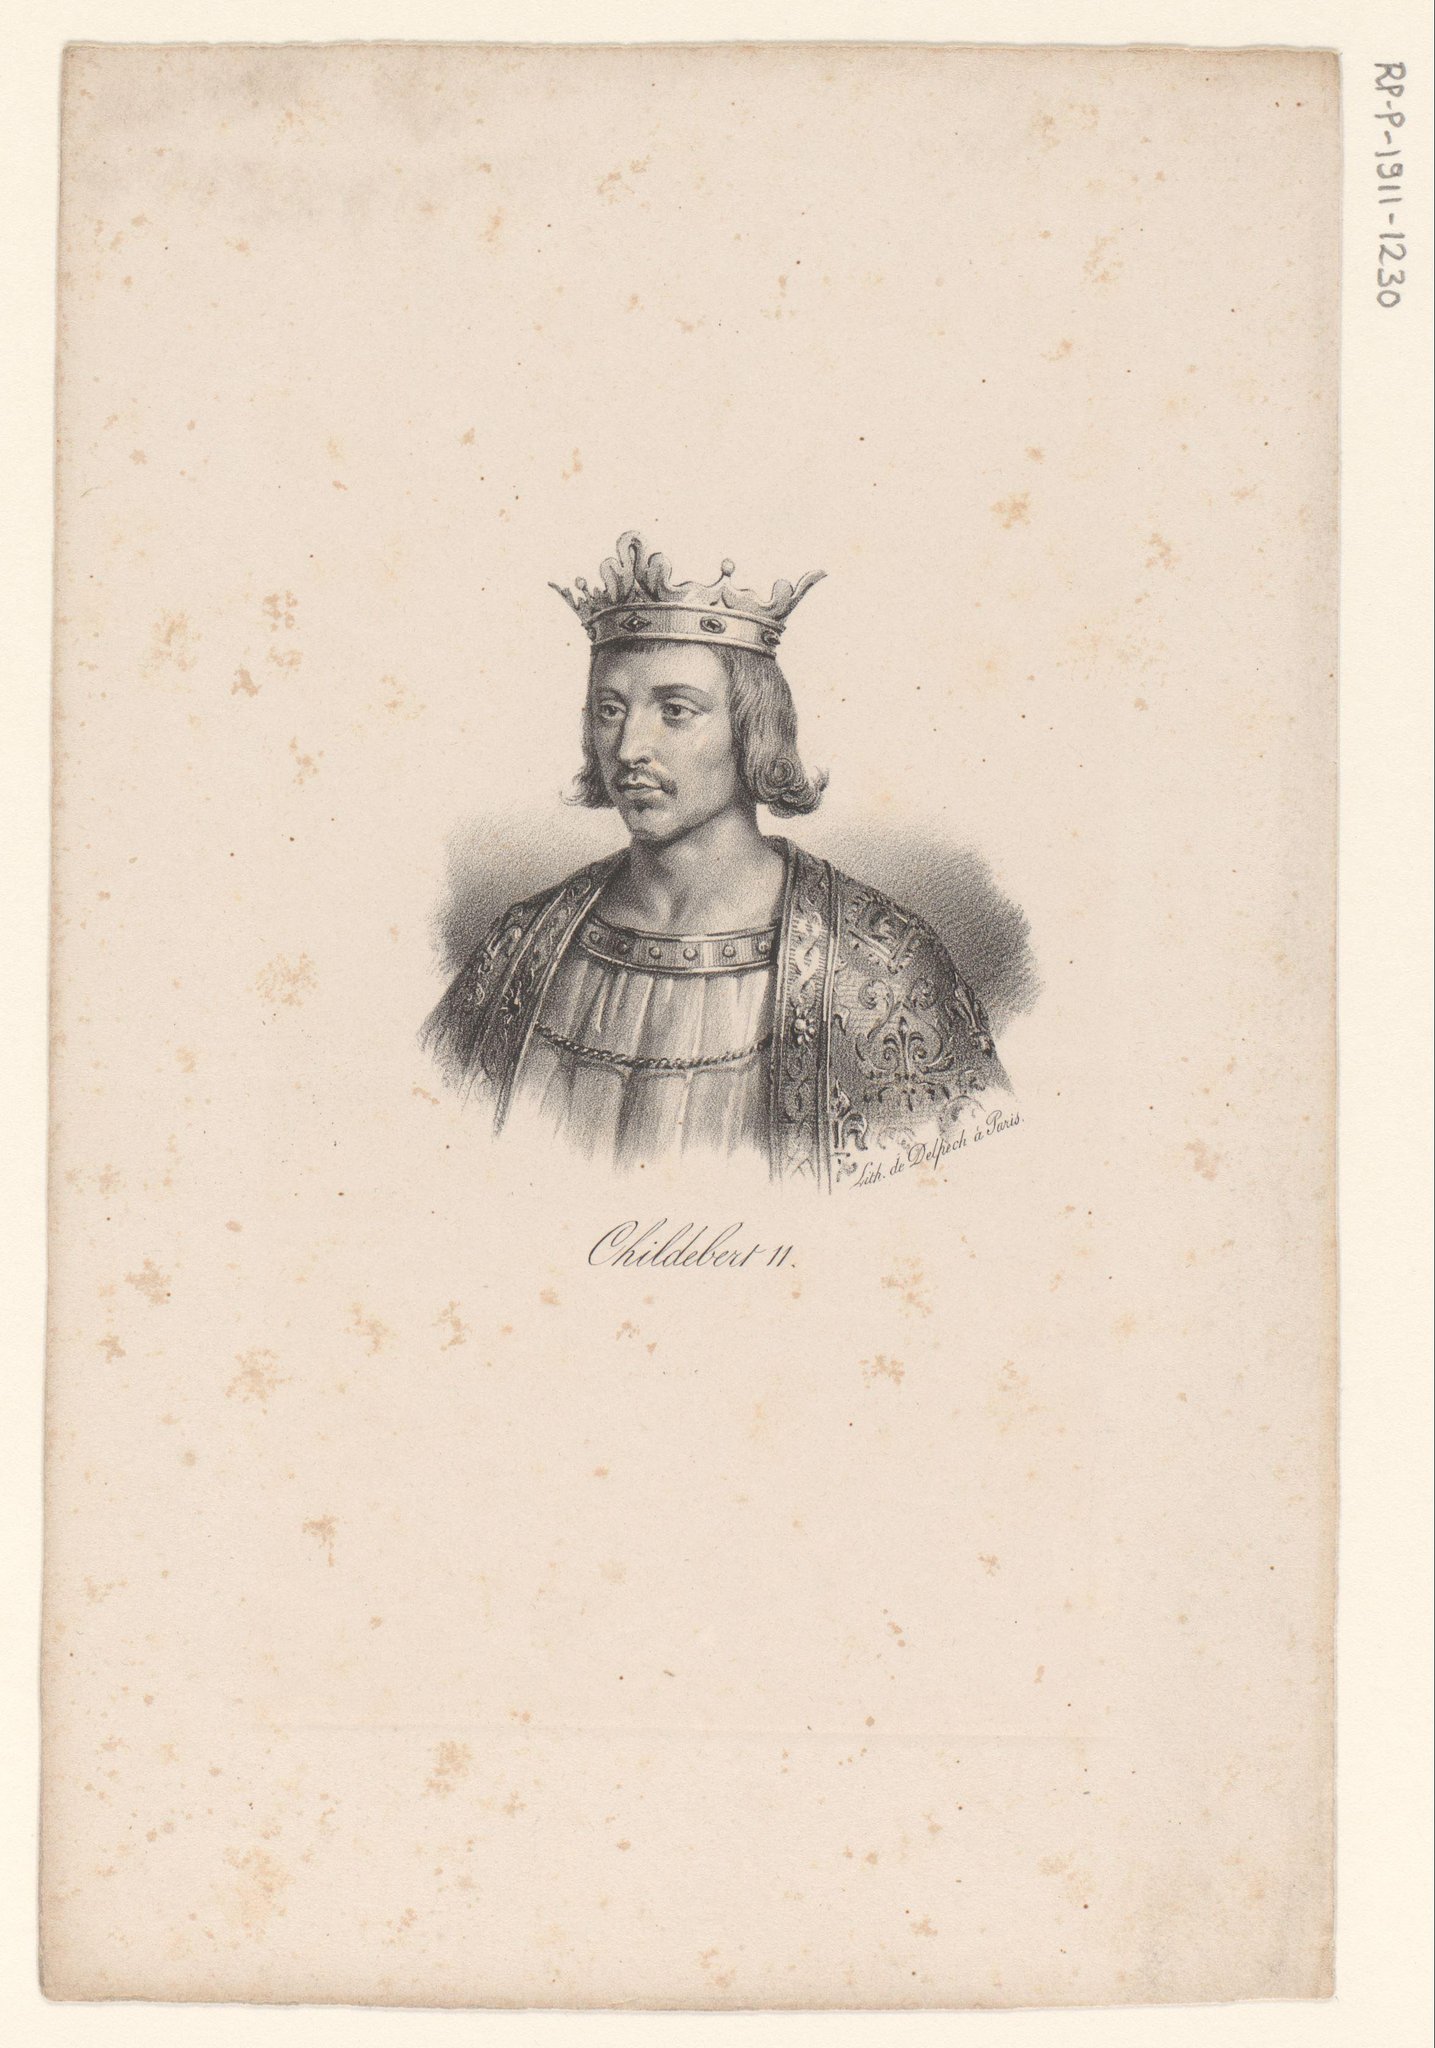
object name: print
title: Portret van koning Childebert II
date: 1818-1842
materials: paper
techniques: lithograph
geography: paris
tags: historical persons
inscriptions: collector's mark: Lugt 2228a